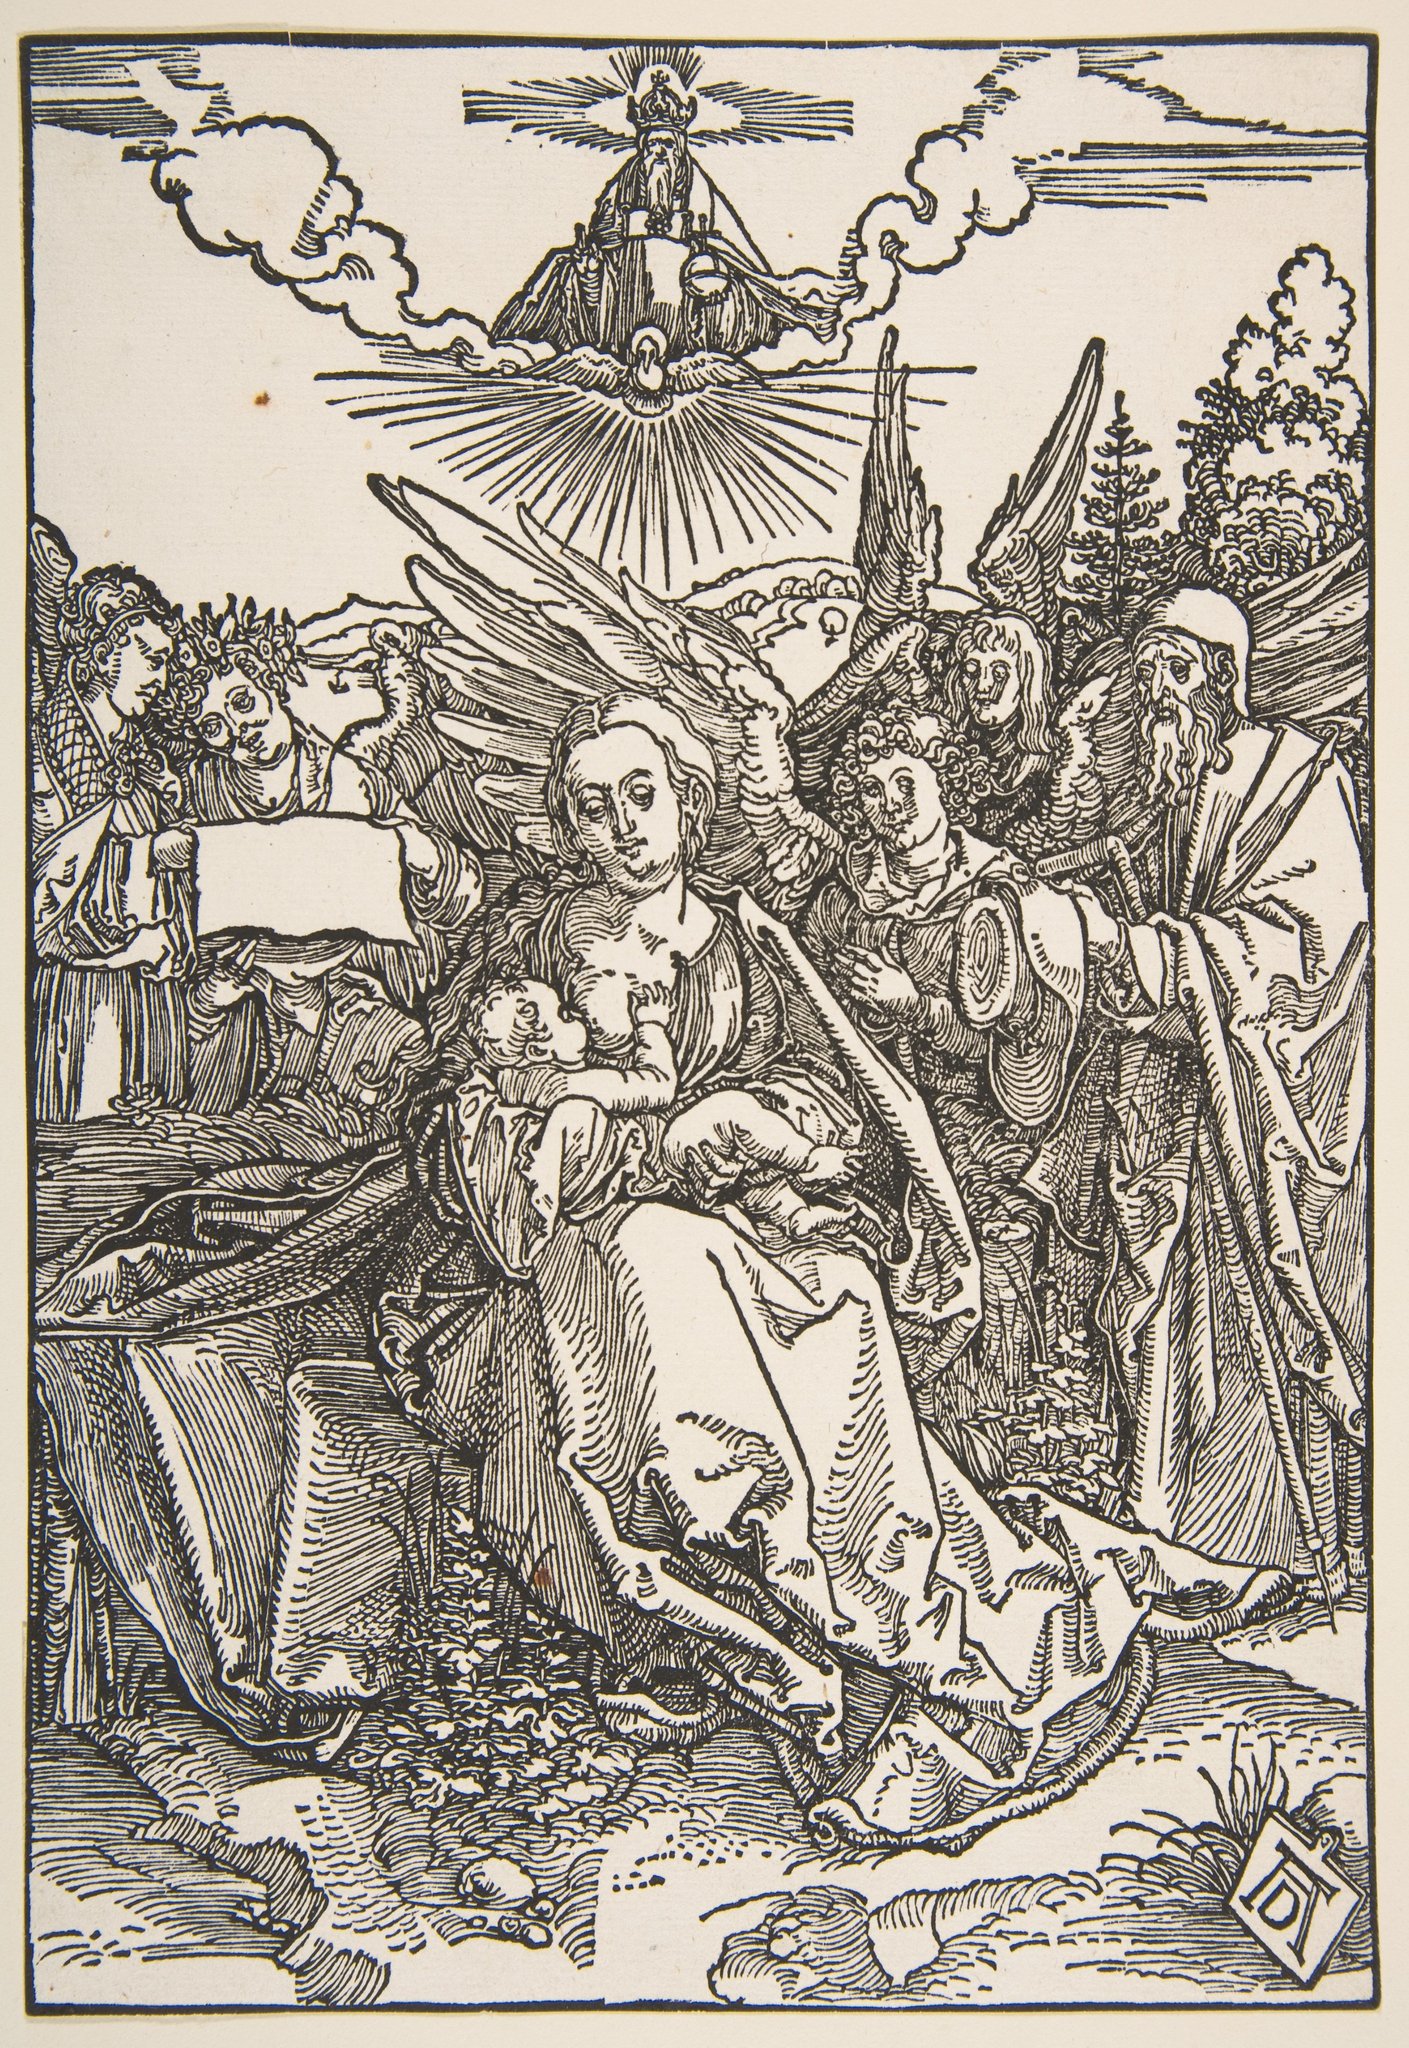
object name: print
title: The Holy Family with Five Angels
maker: albrecht dürer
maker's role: artist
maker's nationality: german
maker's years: 1471-1528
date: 1503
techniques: woodcut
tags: angels,holy family,madonna and child,saint joseph